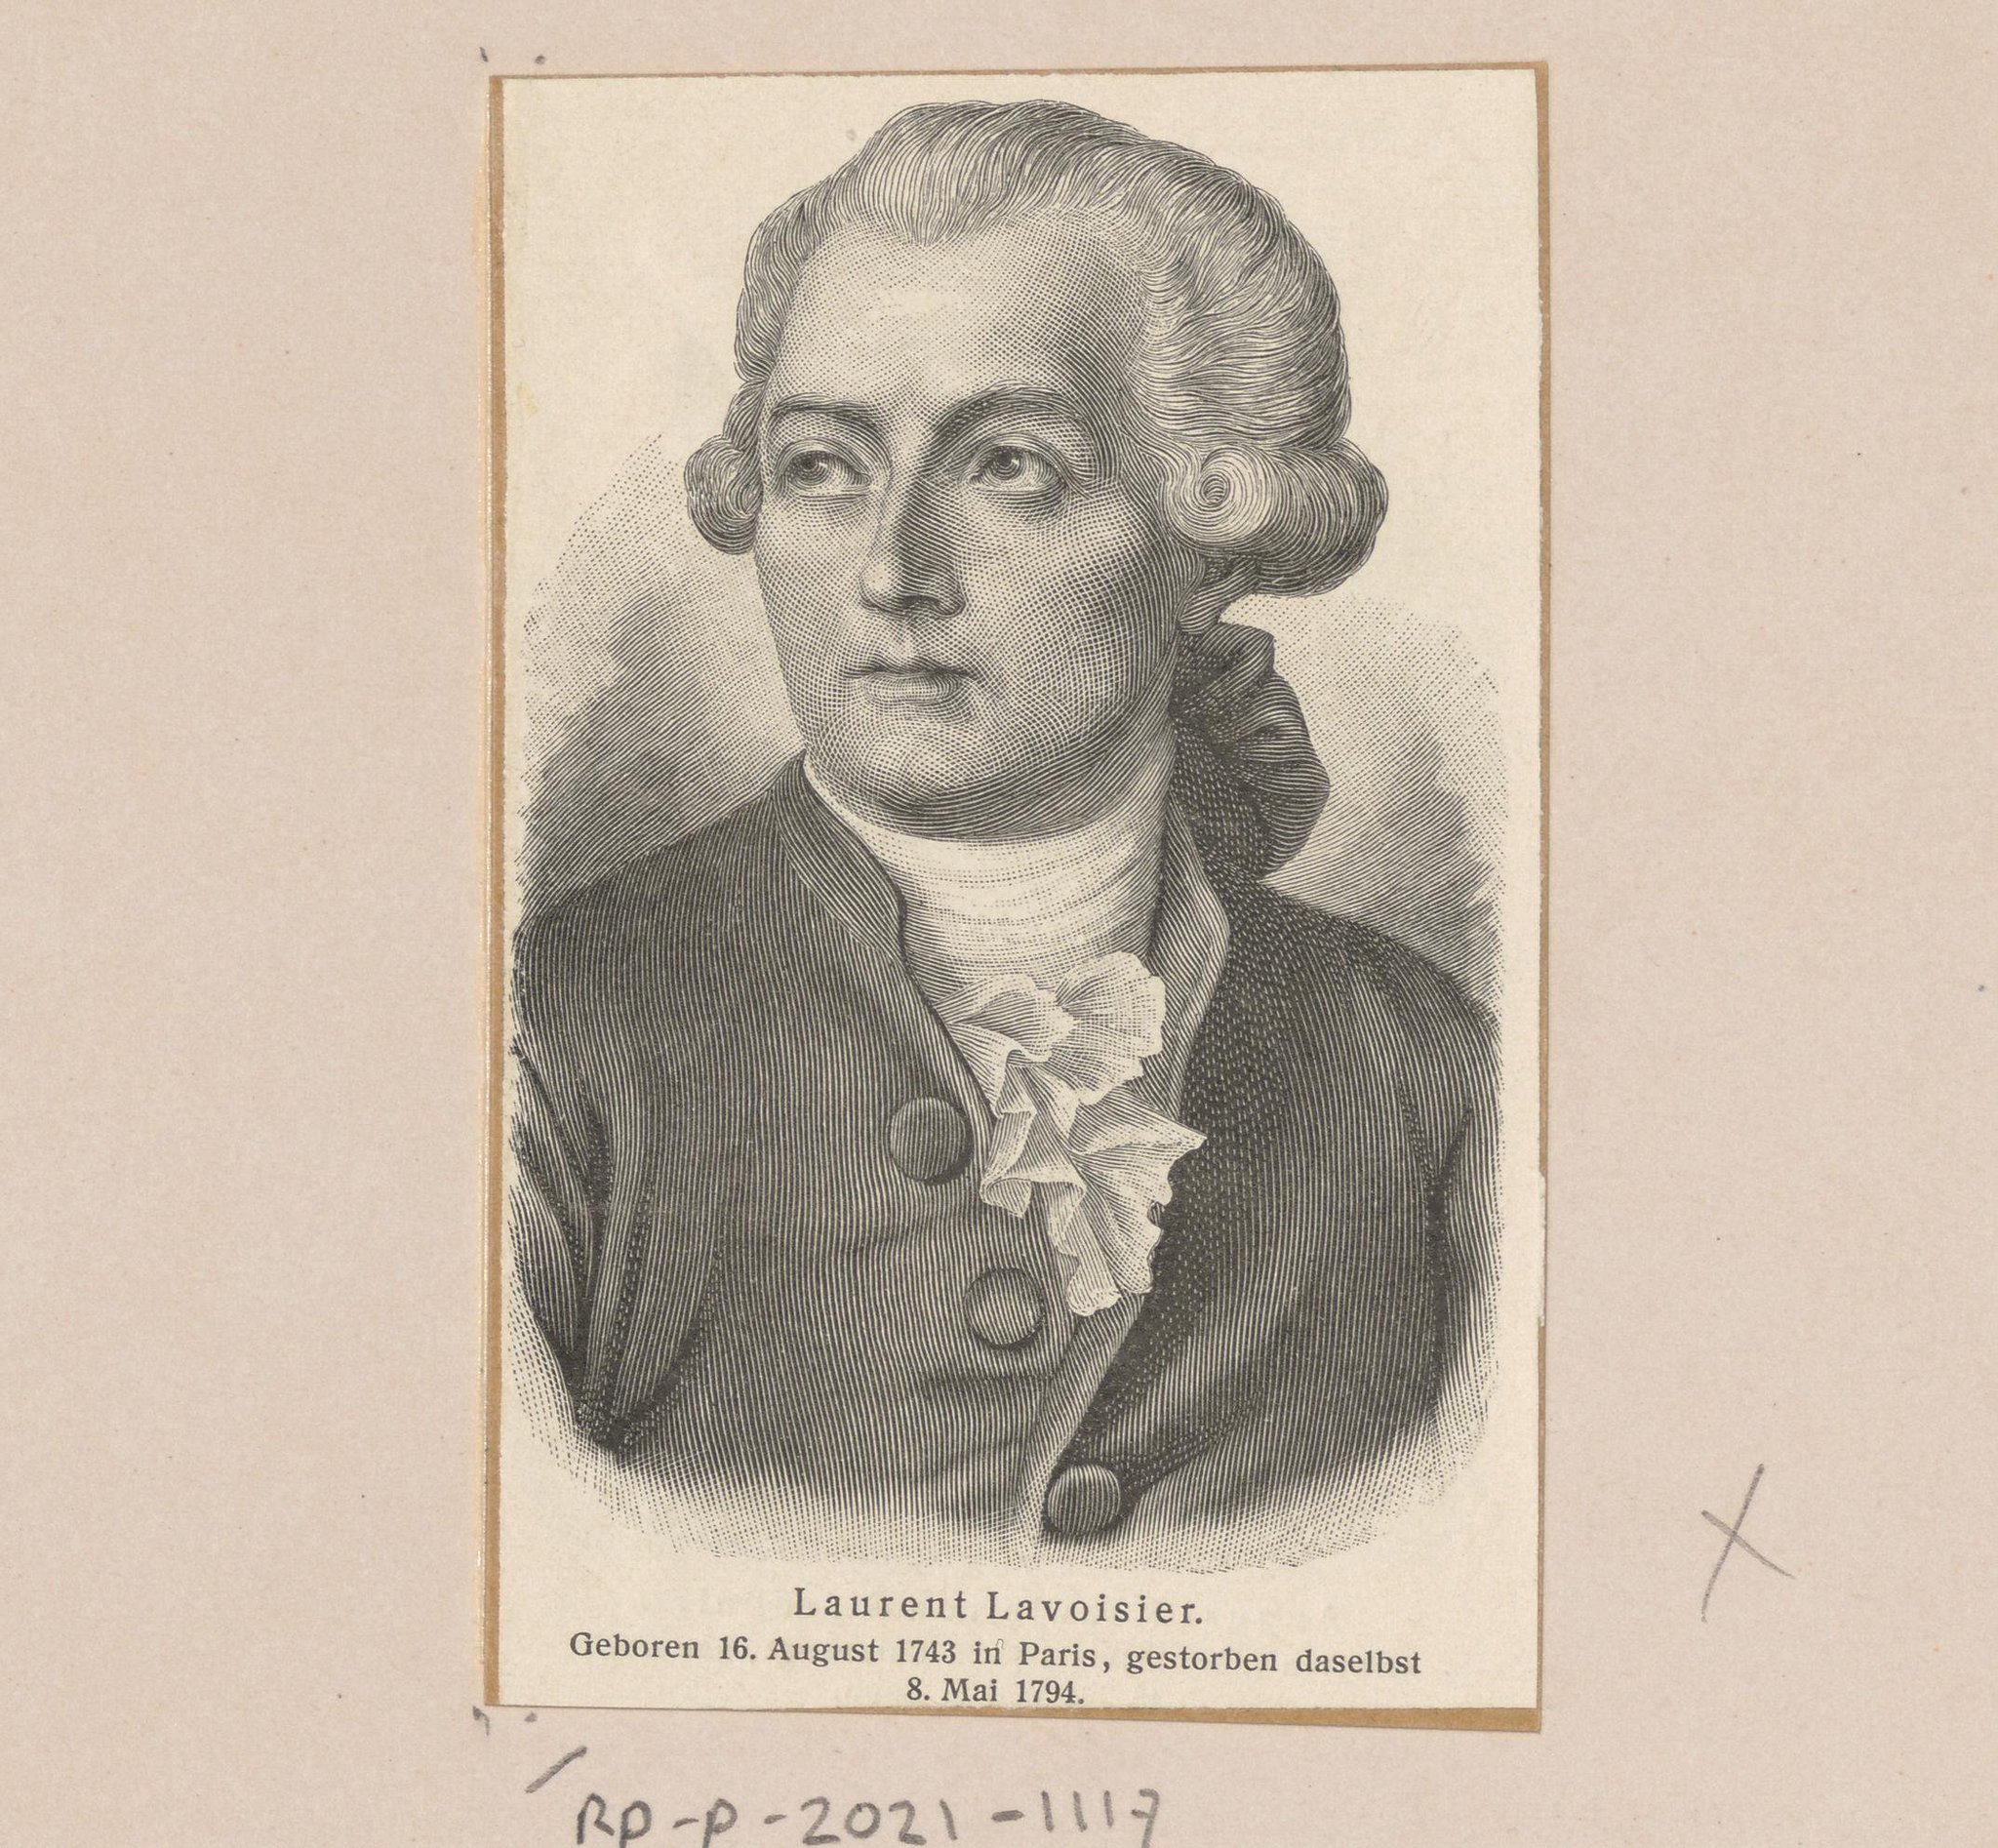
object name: print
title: Portret van Antoine Lavoisier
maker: Anonymous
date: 1800-1899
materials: paper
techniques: letterpress printing, engraving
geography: germany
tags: paris, chemistry (+ portrait of scholar, scientist), historical persons